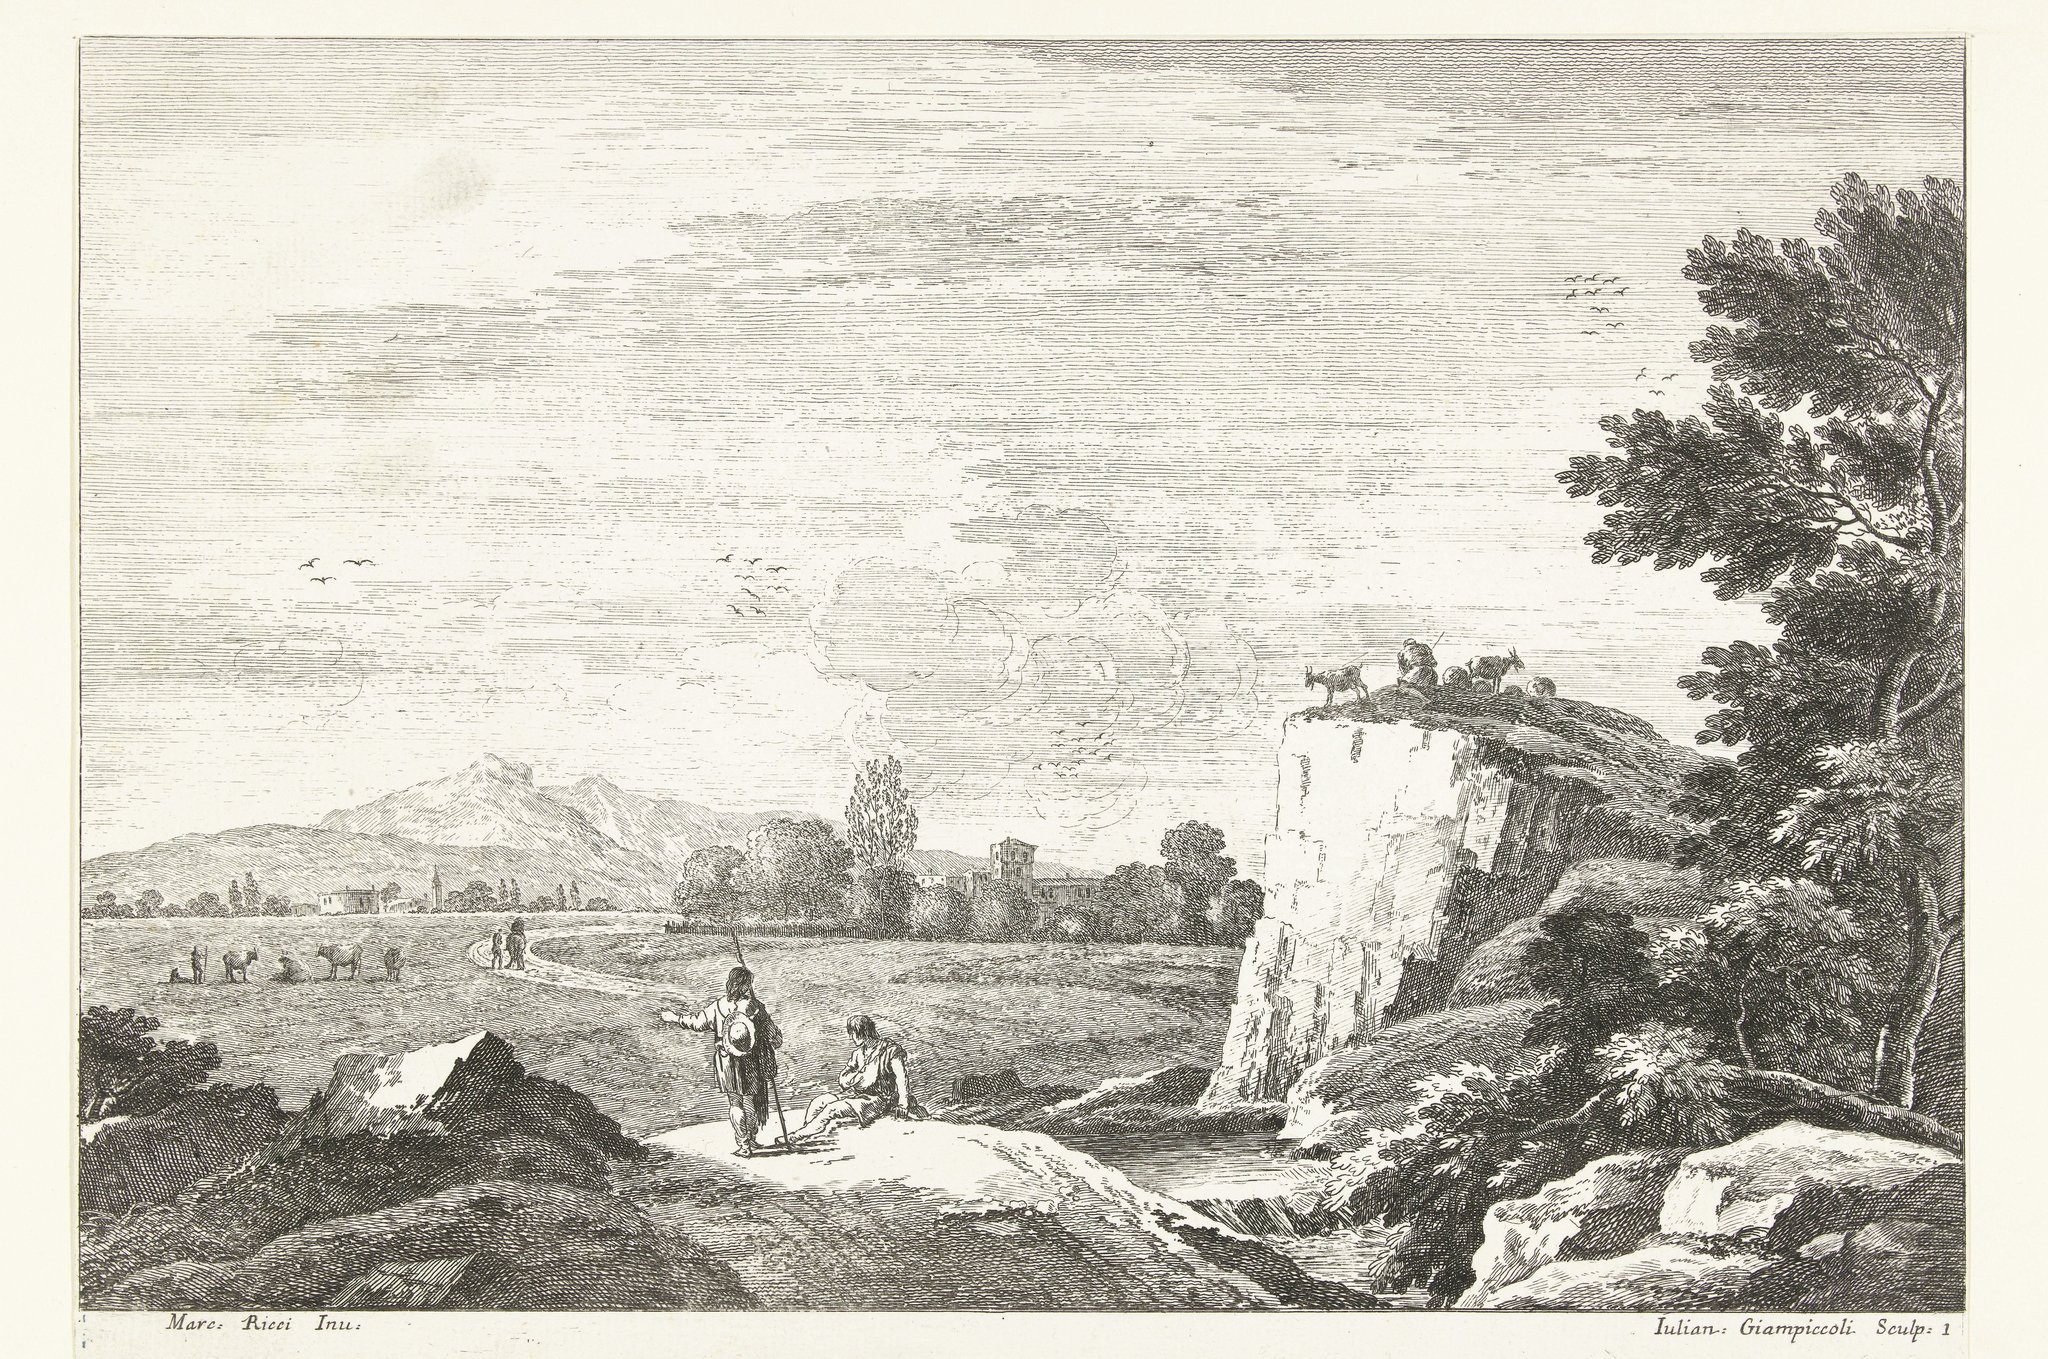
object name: print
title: Landschap met enkele figuren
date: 1739-1740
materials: paper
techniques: etching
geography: venice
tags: landscapes in the temperate zone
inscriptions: collector's mark: Lugt 2228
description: Prent uit eerste serie van achttien prenten met Italiaanse landschappen naar ontwerp van Marco Ricci en titelprent (zie RP-P-1952-20) opgedragen aan consul Joseph Smith.